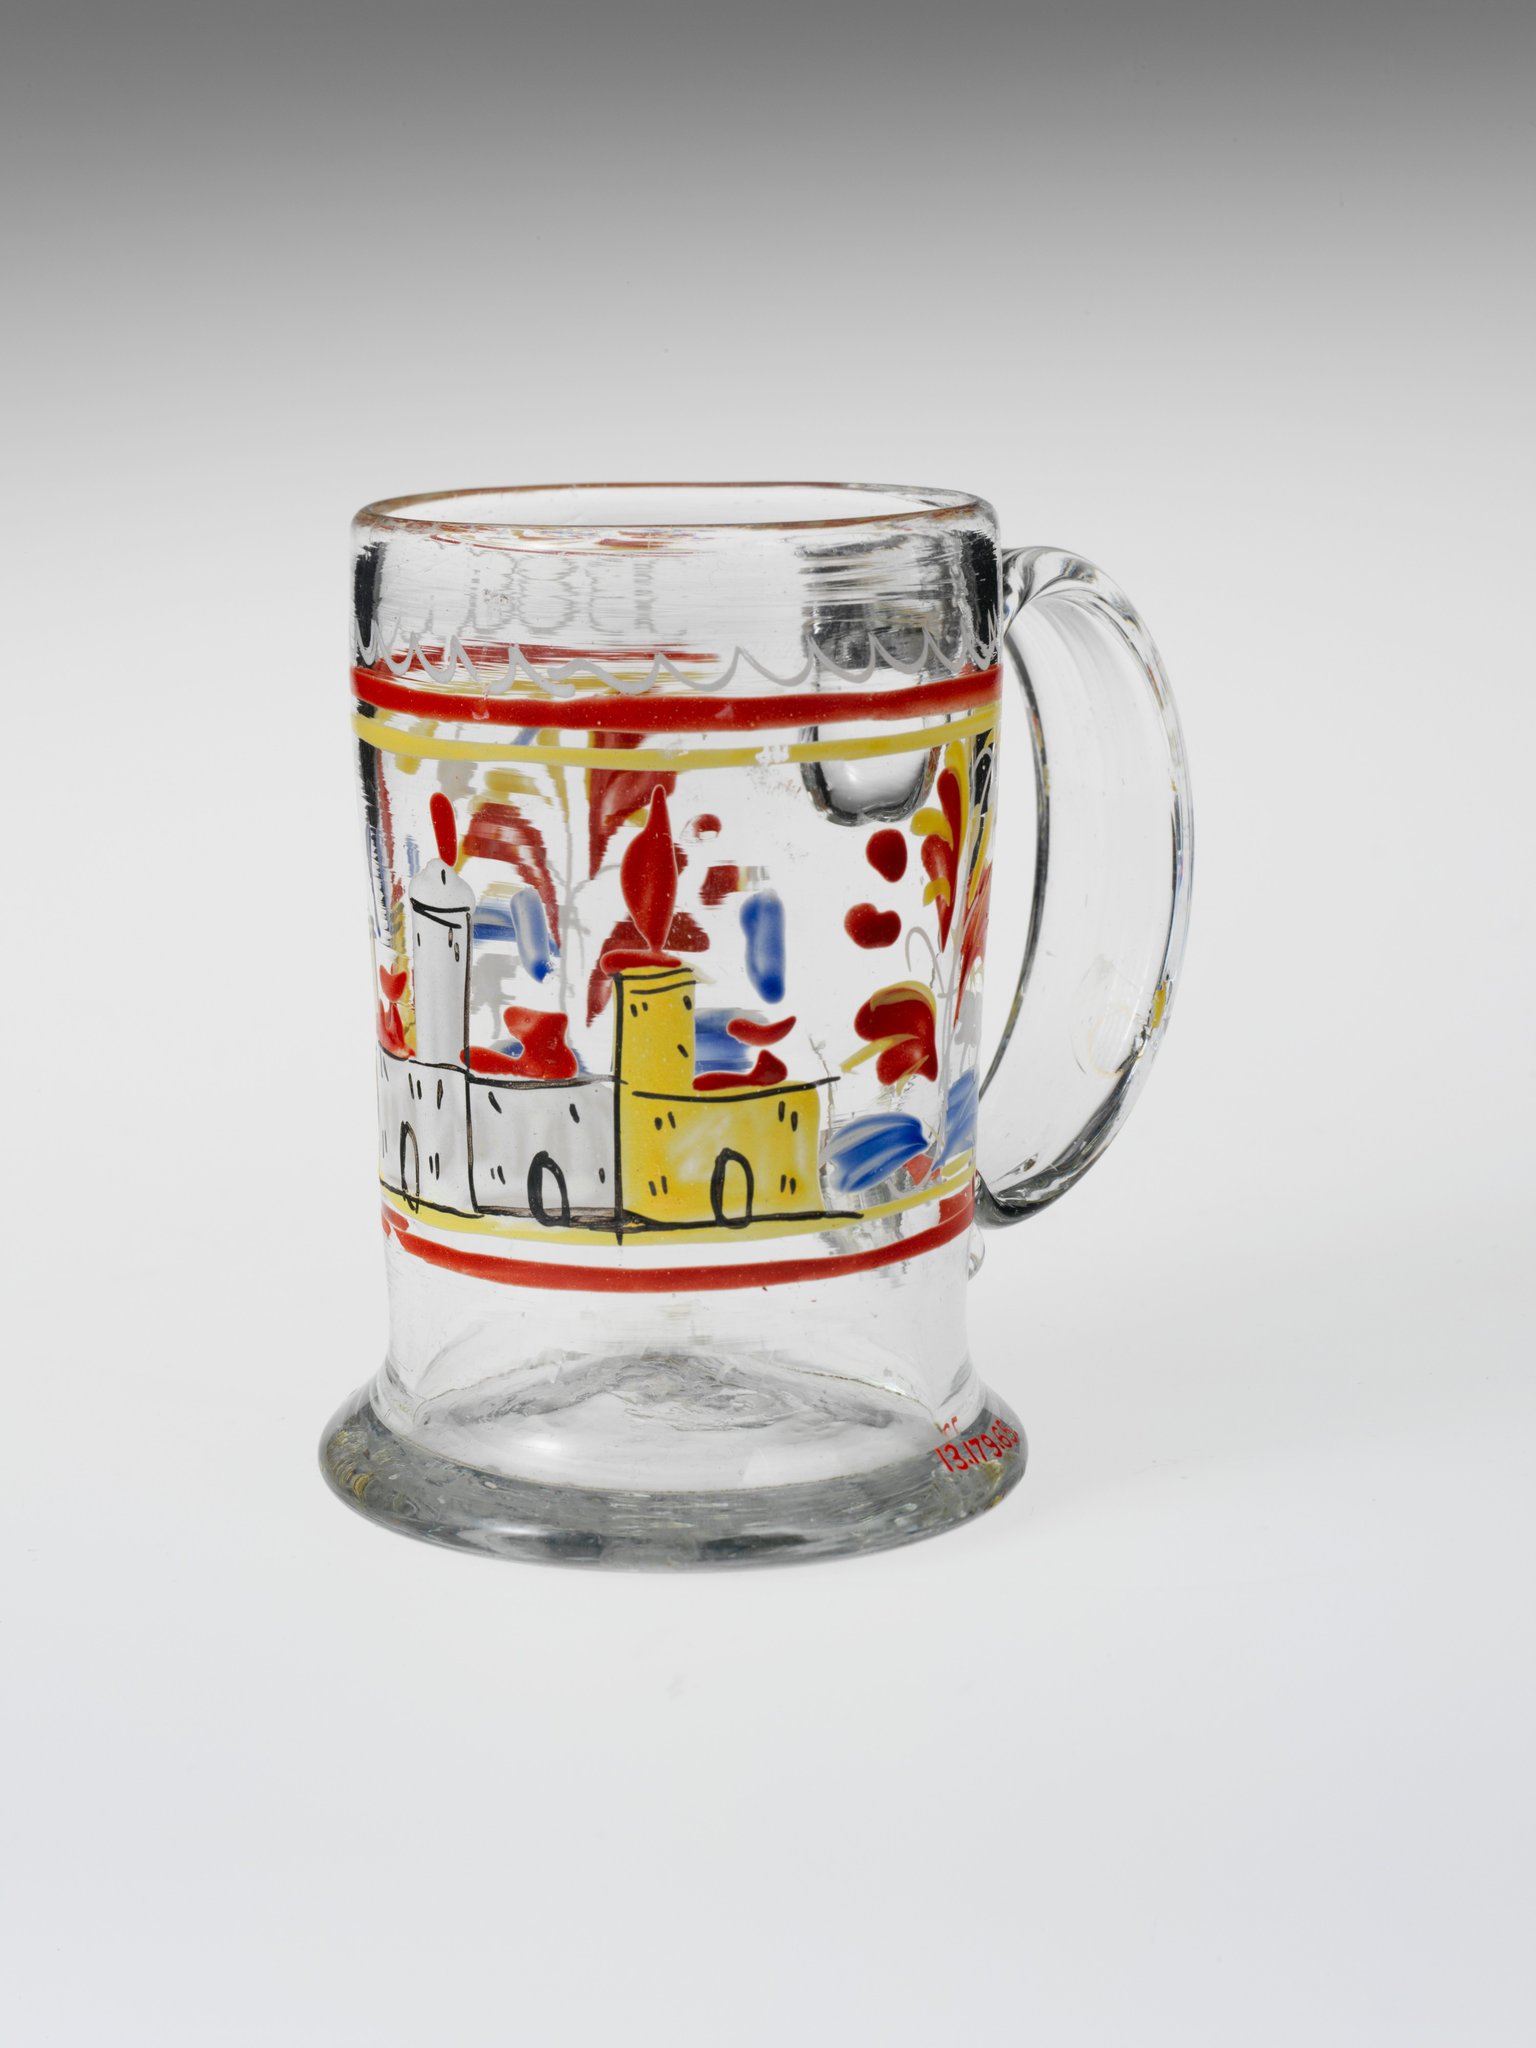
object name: mug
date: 1701-1800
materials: enamel, glass, lead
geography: czech republic